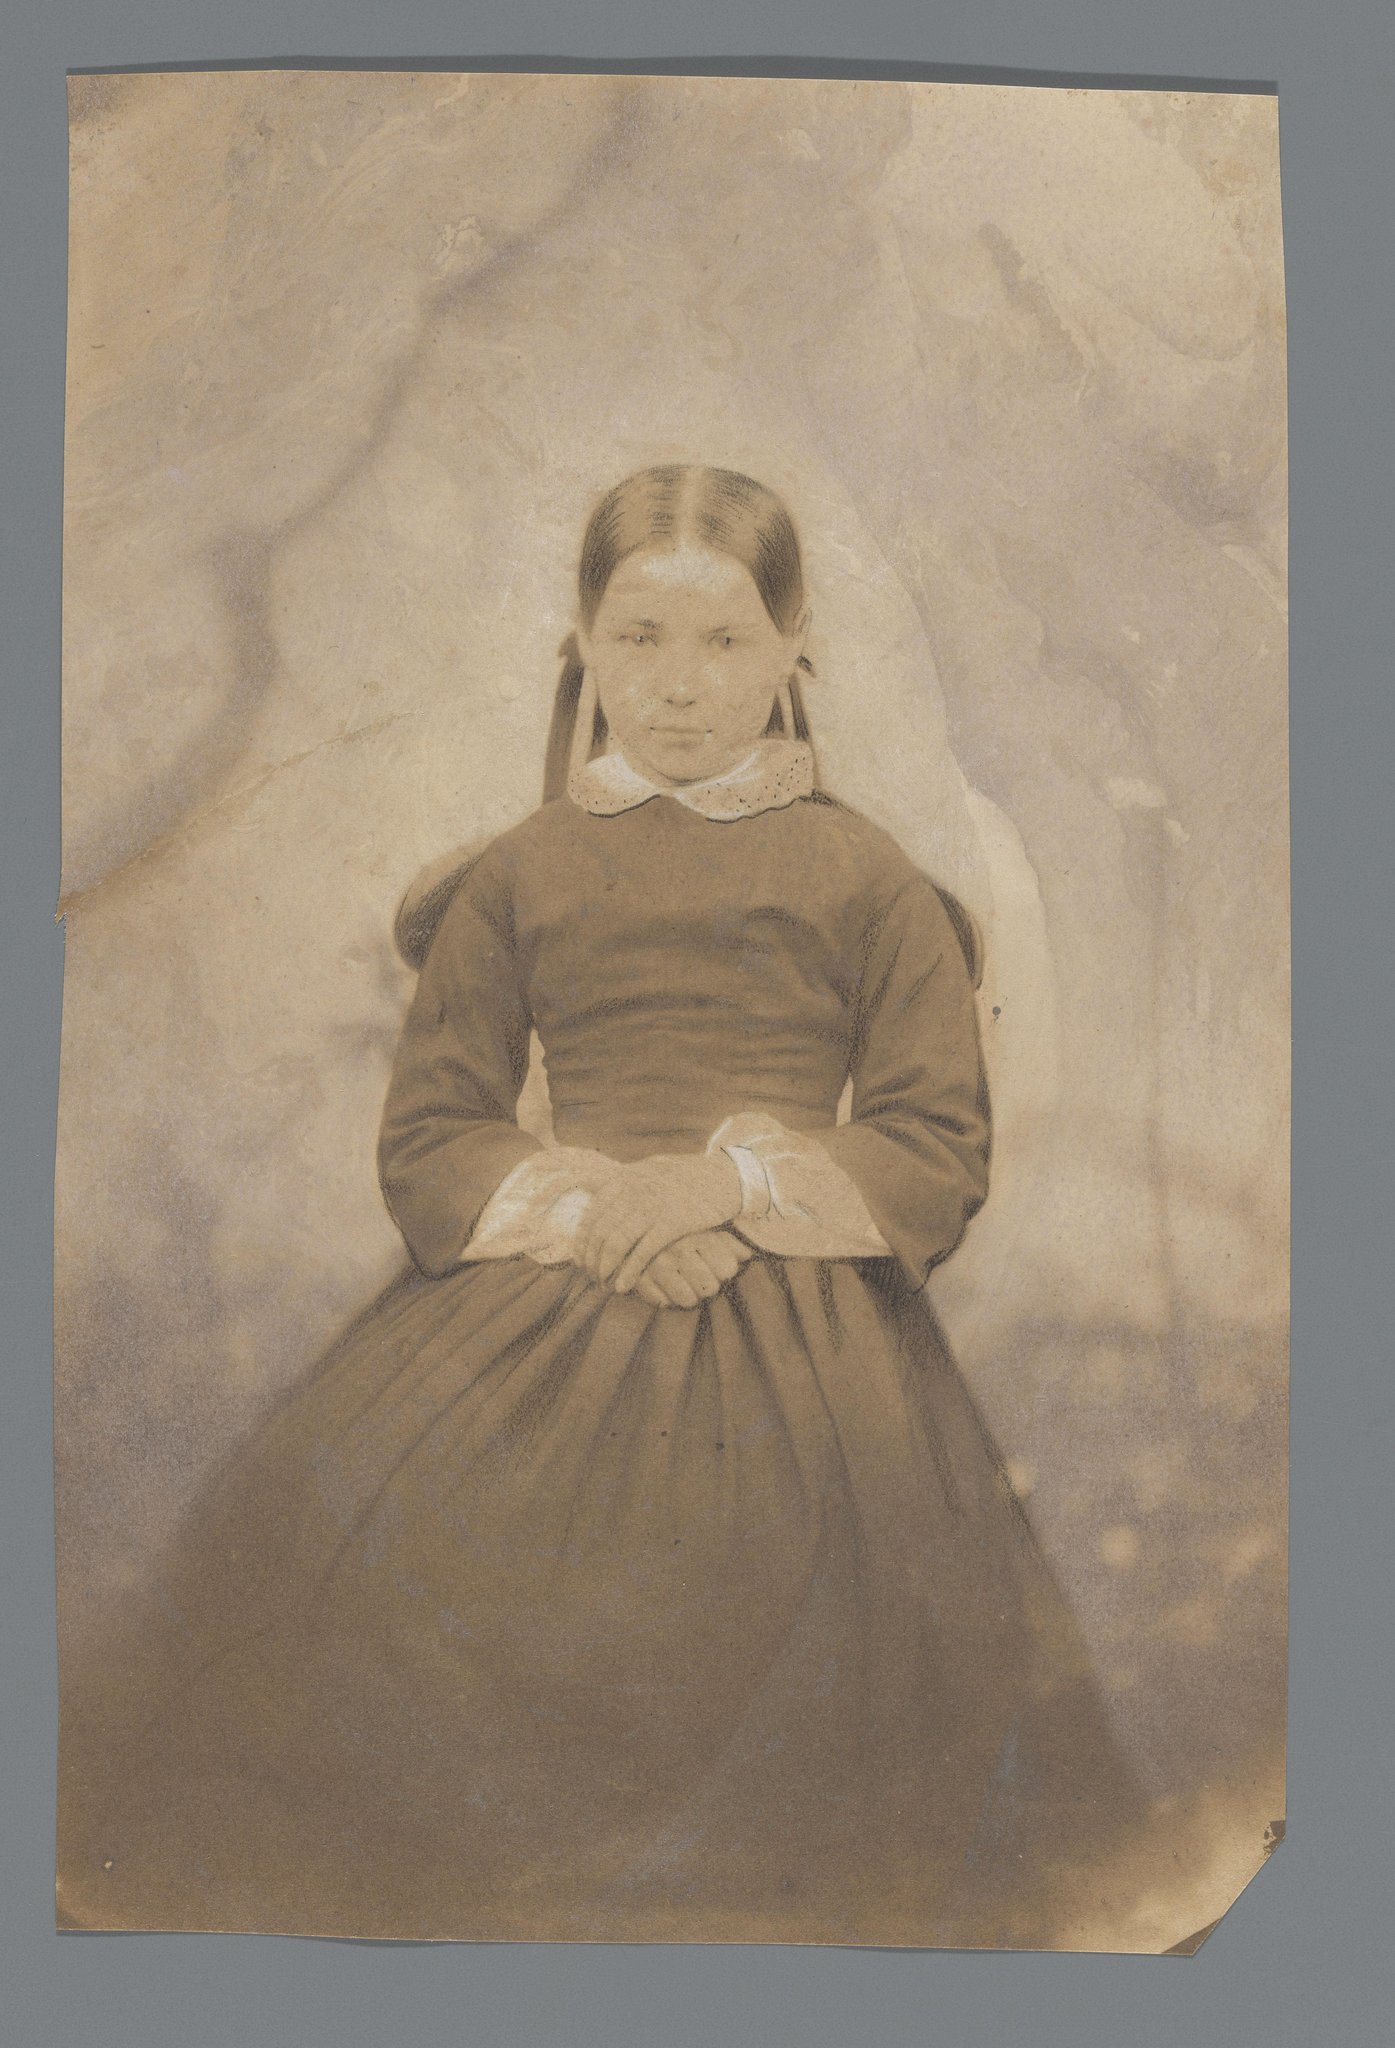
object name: photograph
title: Portret van een meisje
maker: Anonymous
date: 1850-1920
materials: photographic support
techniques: salted paper print